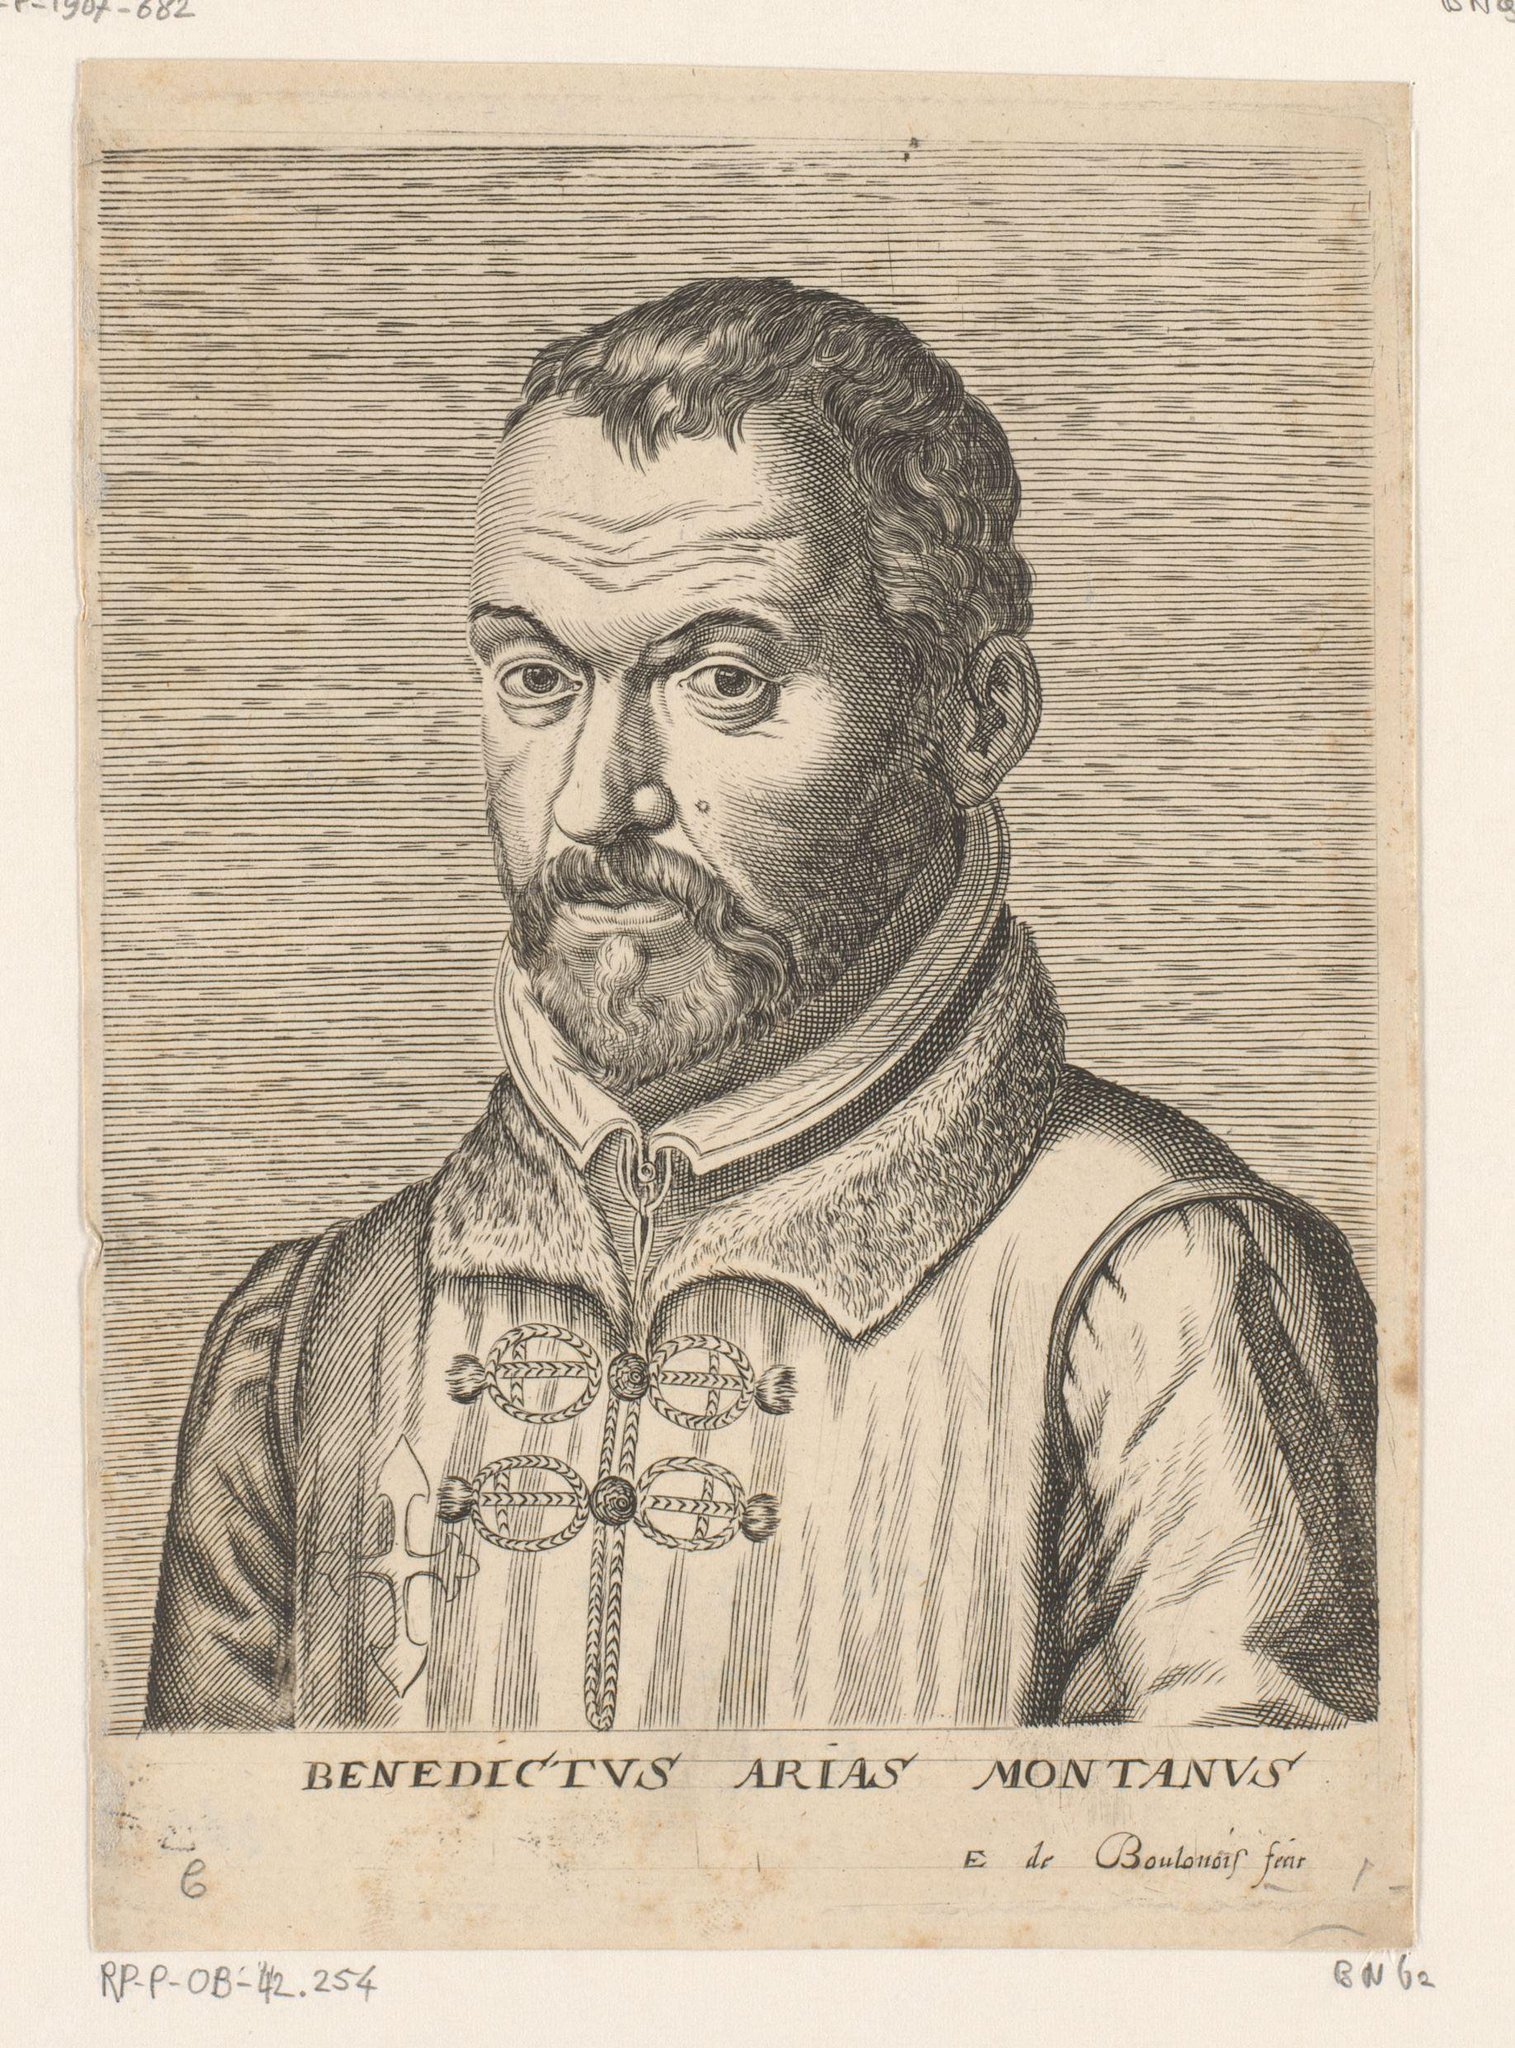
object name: book illustration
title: Portret van Benedictus Arias Montanus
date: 1682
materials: paper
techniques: engraving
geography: brussels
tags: benedictus arias montanus, scholar, philosopher, historical persons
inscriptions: collector's mark: Lugt 2228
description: Prent uit: Bullert, Isaac. Académie des Sciences et Arts contenant les vies et éloges his. des hommes illustres qui ont excellé en ces professions depuis environ quatre siècles. Brussel: Foppens, François, 1682. Het boek werd in 1682 eveneens in Amsterdam uitgegeven door de erfgenamen van Daniel Elzevier. Deze portretten dienen ter illustratie van de biografie van een kunstenaar of geleerde. De meeste portretten werden door Nicolas de Larmessin vervaardigd (162), 93 door De Boulonois en een derde door ongeïdentificeerde prentmakers. Dit betreft een illustratie op p. 45, deel II.